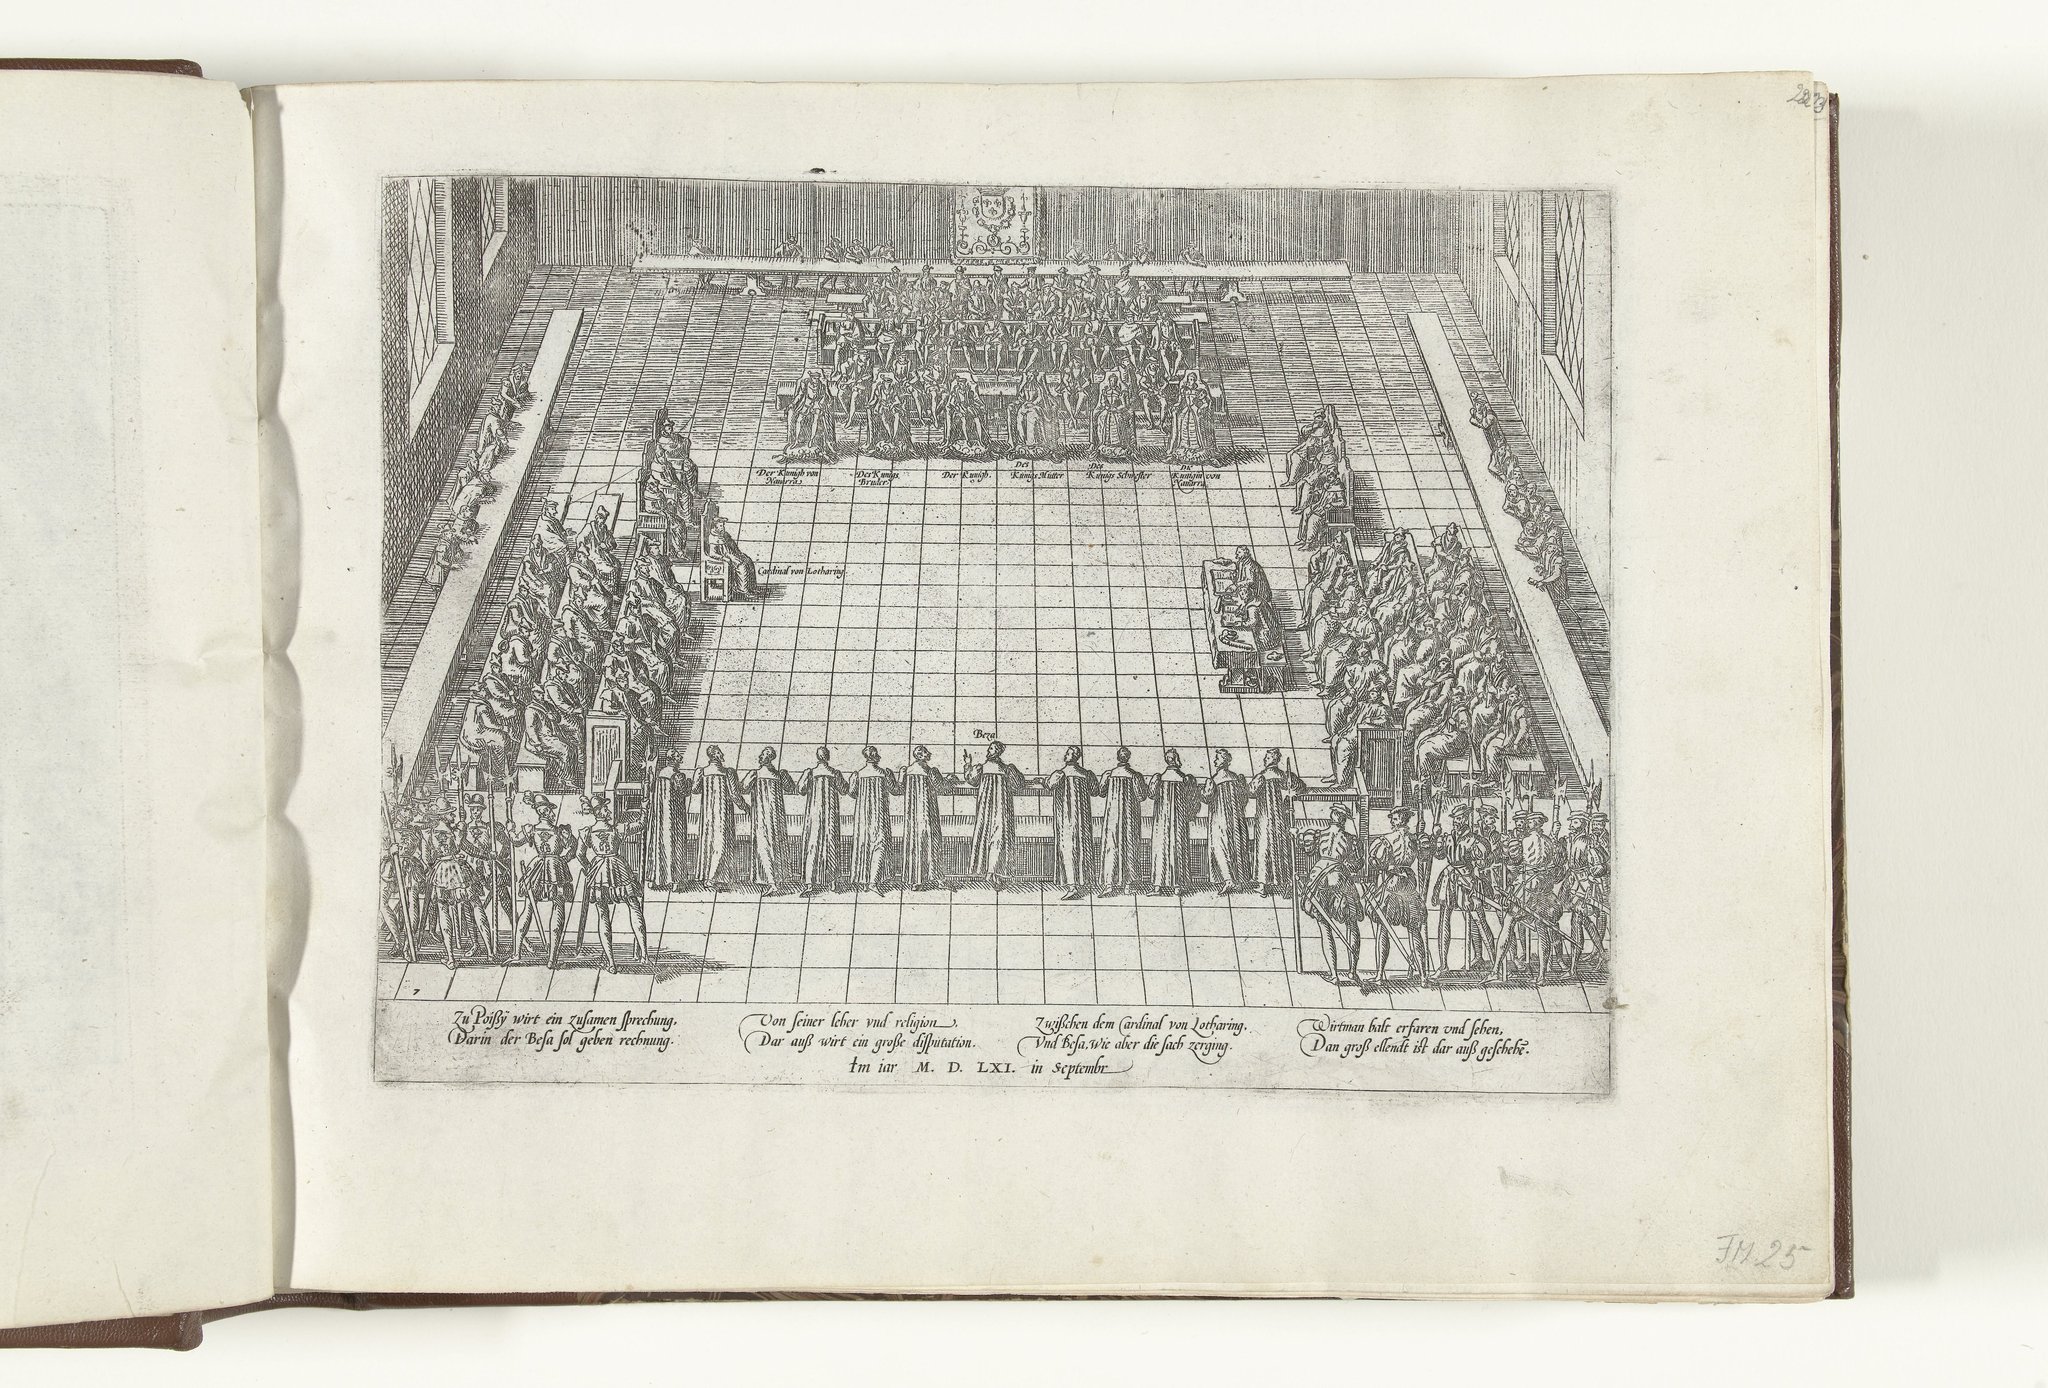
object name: album leaf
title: Colloquium te Poissy, 1561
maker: frans hogenberg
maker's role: print maker, publisher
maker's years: 1538-1590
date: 1565-1573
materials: paper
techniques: etching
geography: cologne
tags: theodorus beza, karel ix (koning van frankrijk)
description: Gekopieerd naar de prent in: Jean Tortorel et Jacques Perrissin, Premier volume contenant quarante tableaux ou Histoires diverses qui sont memorables touchant les Guerres, Massacres et Troubles advenus en France en ces dernieres annees : le tout recueilly selon le tesmoignange de ceux qui y ont esté en personne et qui les ont veus : lesquels sont pourtraits à la vérité, Genève ca. 1570. Bibliotheek Rijksmuseum: 329 A 2, pl. 10.